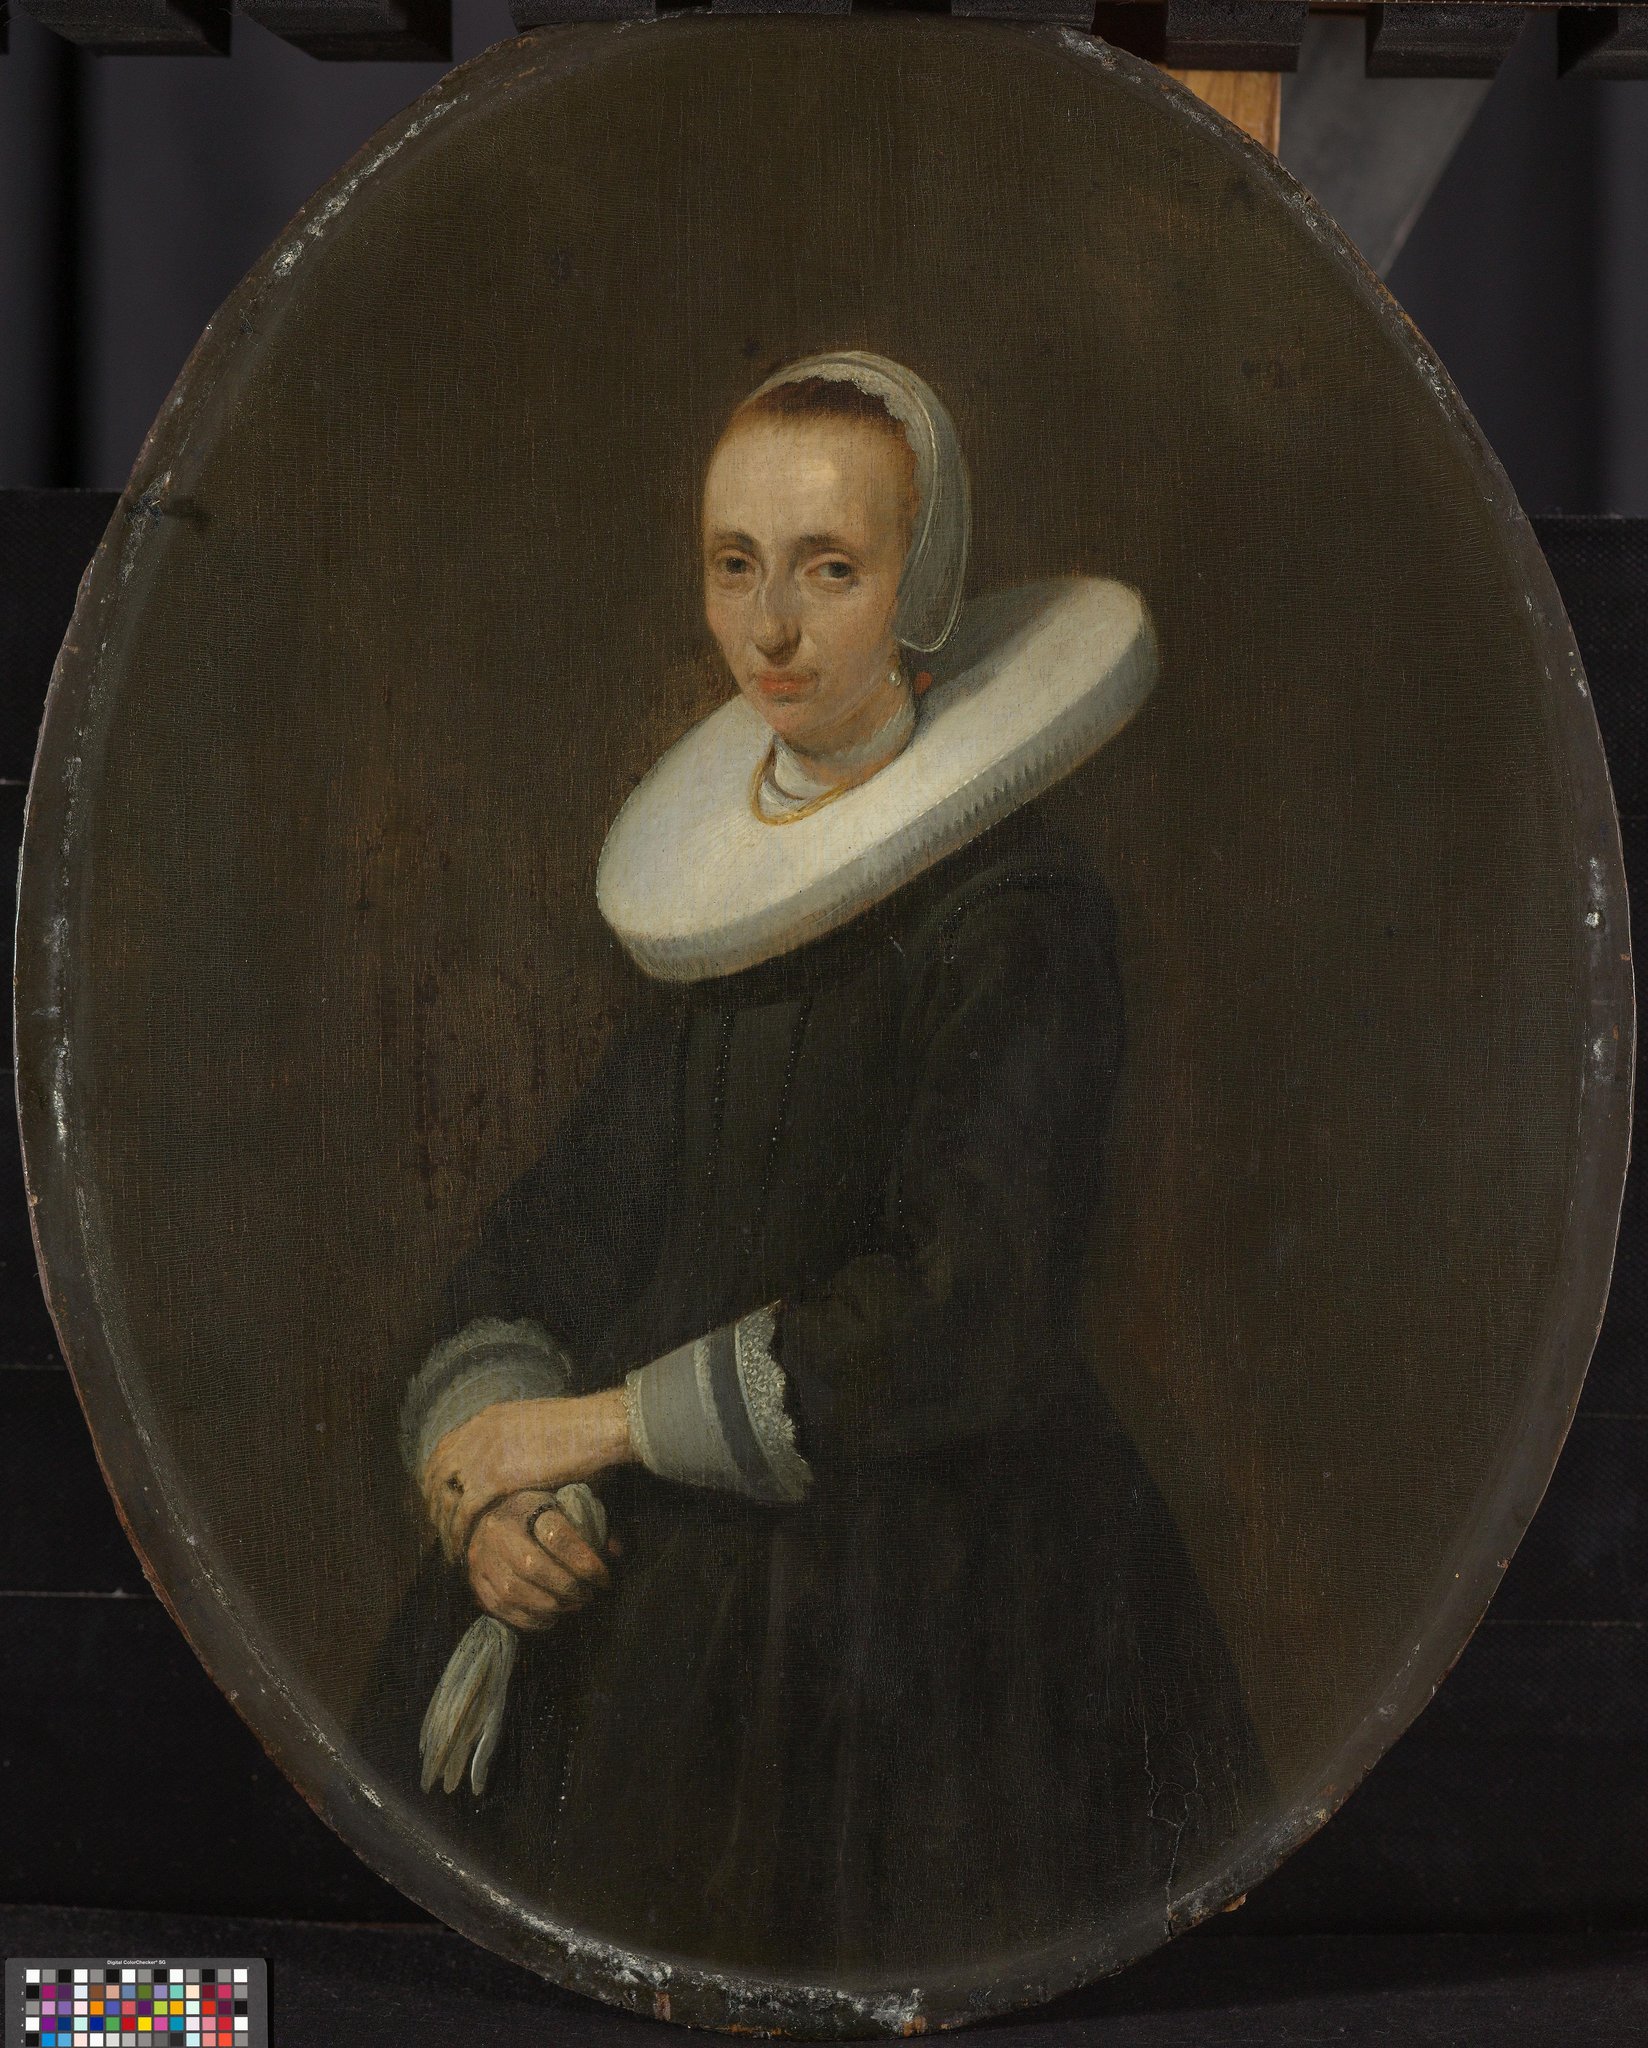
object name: painting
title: Portrait of Johanna Bardoel (d. after 1667)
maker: gerard ter borch (ii)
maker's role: draughtsman, painter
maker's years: 1617-1681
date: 1644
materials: oil, panel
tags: haarlem, historical persons - bb - woman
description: Portret van Johanna Bardoel (gest. na 1667), getrouwd met Gerard van der Schalcke. Kniestuk, staande met een handschoen in de rechterhand. Pendant van SK-A-1784.